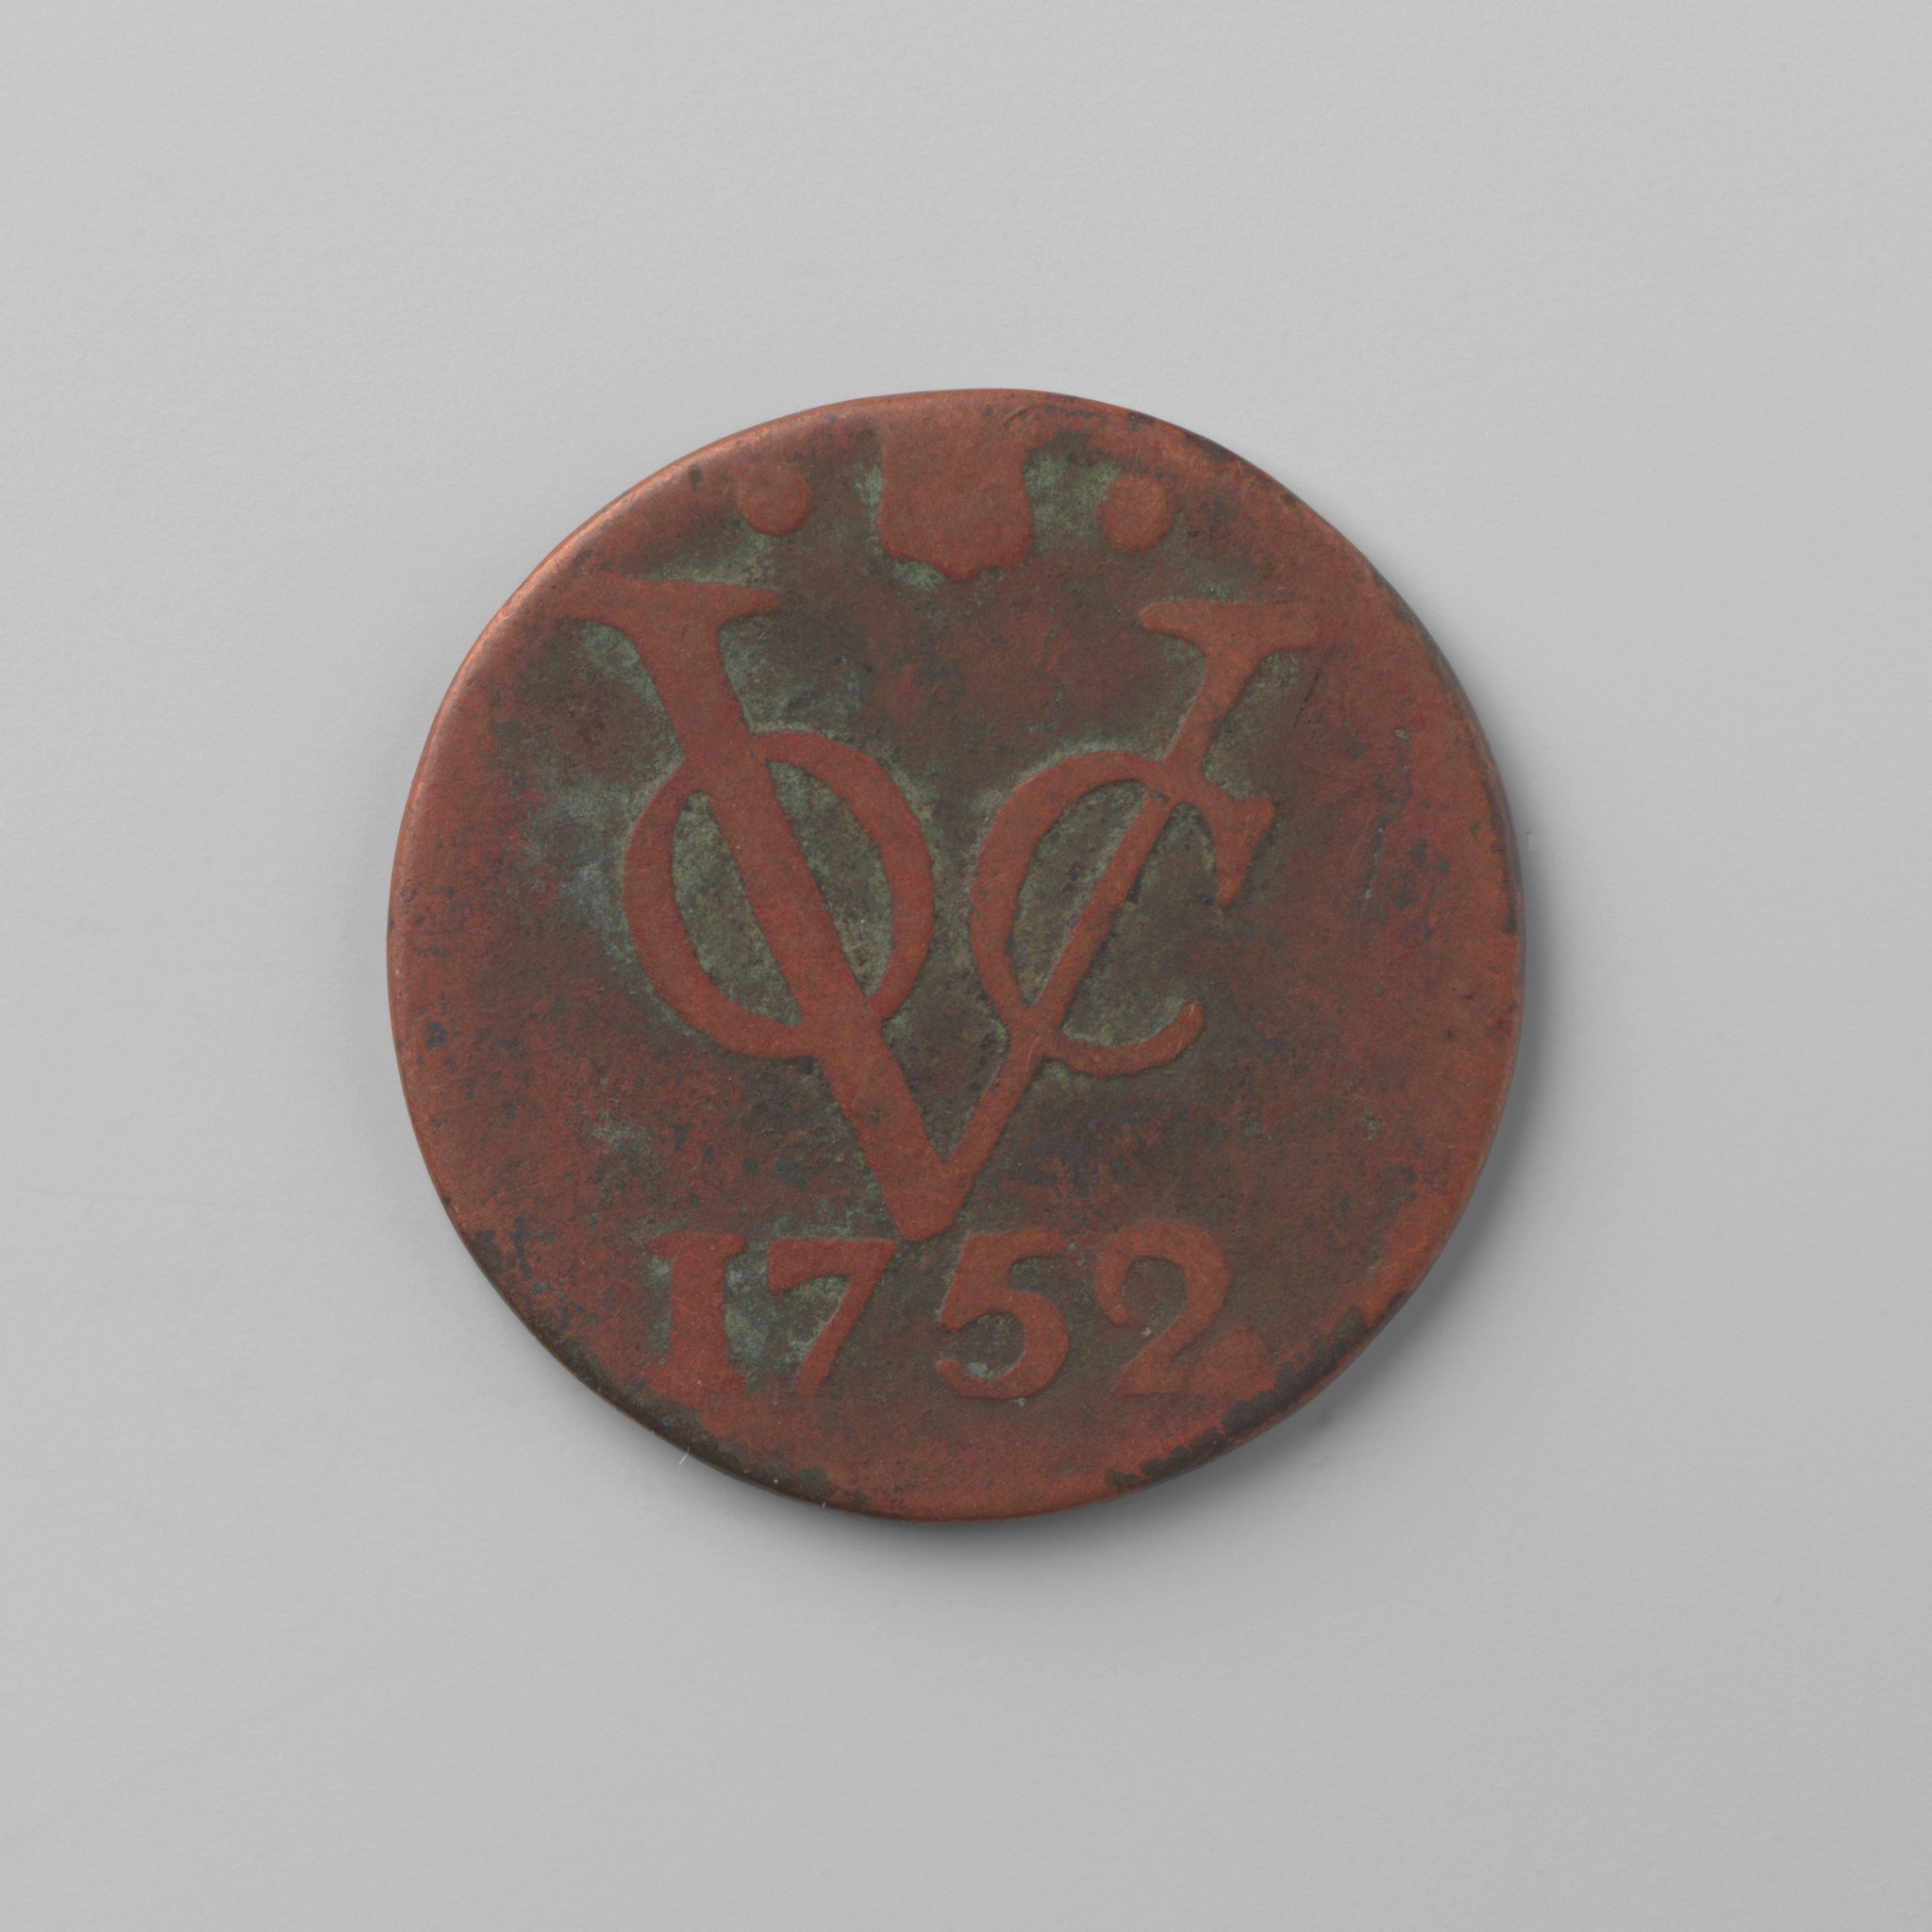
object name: coin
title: Duit van de VOC uit de stad Utrecht,1752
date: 1752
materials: copper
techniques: striking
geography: utrecht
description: Koperen munt. Voorzijde: op balk, waaronder guirlande, geplaatst, door twee leeuwen gehouden gekroond wapenschild van de stad Utrecht. Keerzijde: monogram van de VOC, waarboven muntteken en waaronder jaartal. Gladde rand.